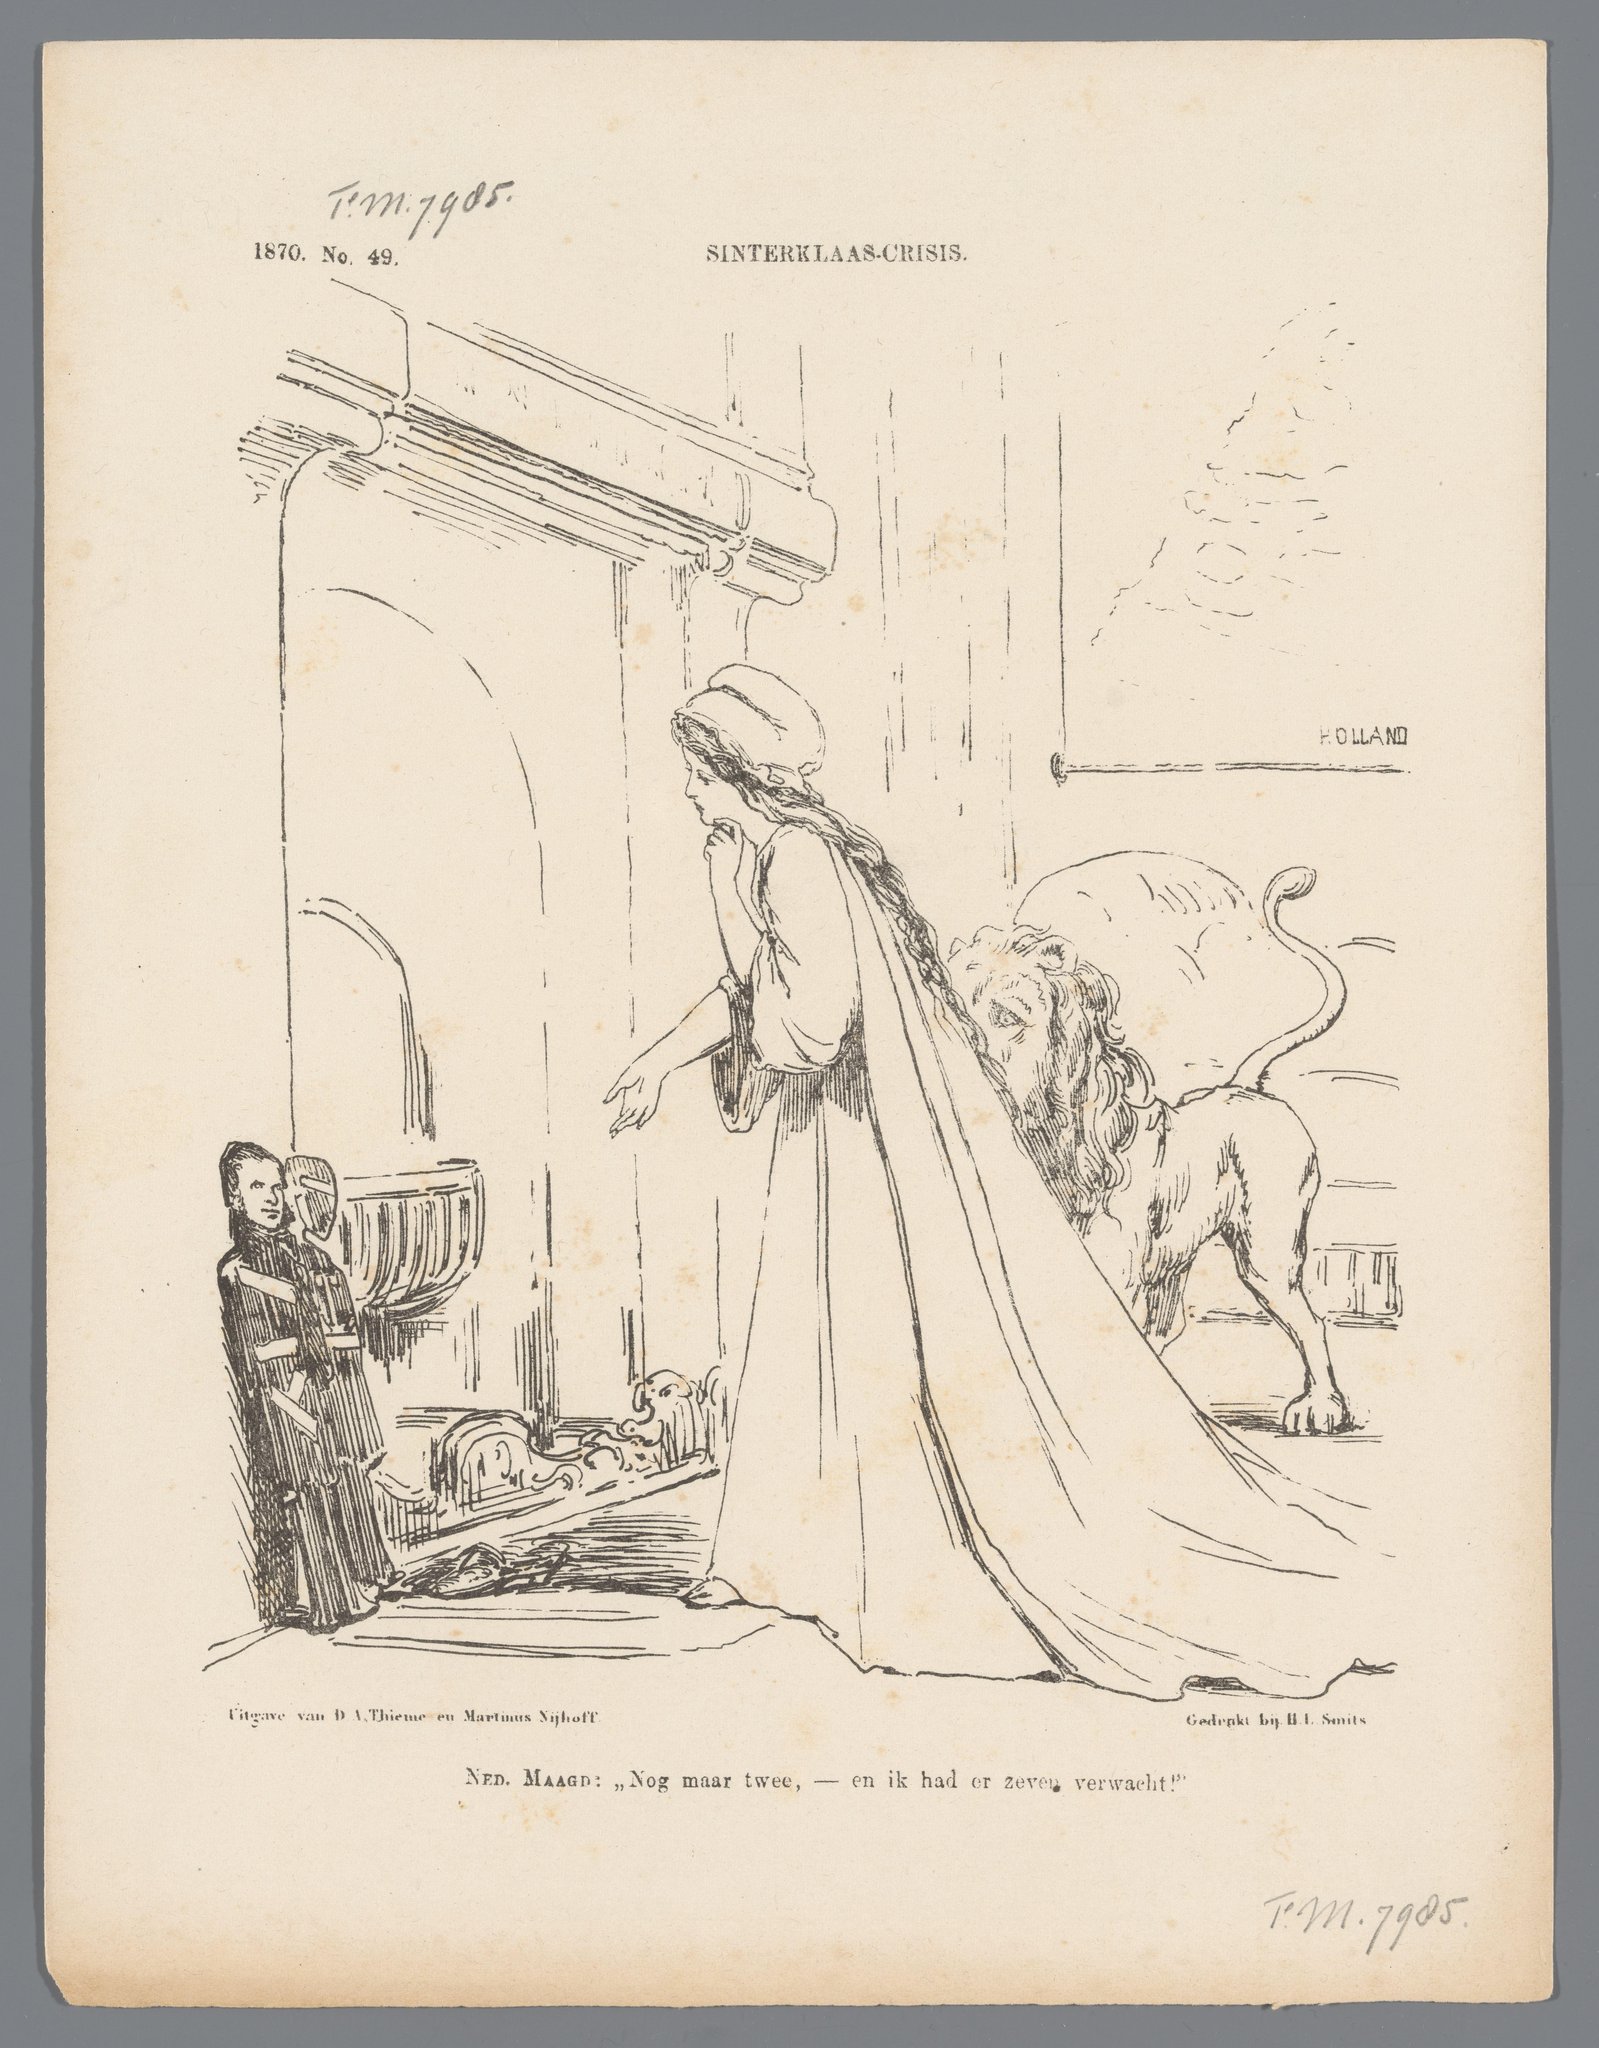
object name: print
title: Sinterklaas-crisis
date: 1870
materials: paper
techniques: lithograph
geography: netherlands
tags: minister ~ government, personifications of countries, nations, states, districts, etc., festivities on st. nicholas (eve) (december 5), saint nicholas day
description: Spotprent op de langdurige ministeriële krisis. De Nederlandse Maagd vindt op Sinterklaas tot haar teleurstelling slechts twee ipv zeven poppen (ministers) bij de haard. Plaat verschenen bij het weekblad De Nederlandsche Spectator, nr. 49, 1870.